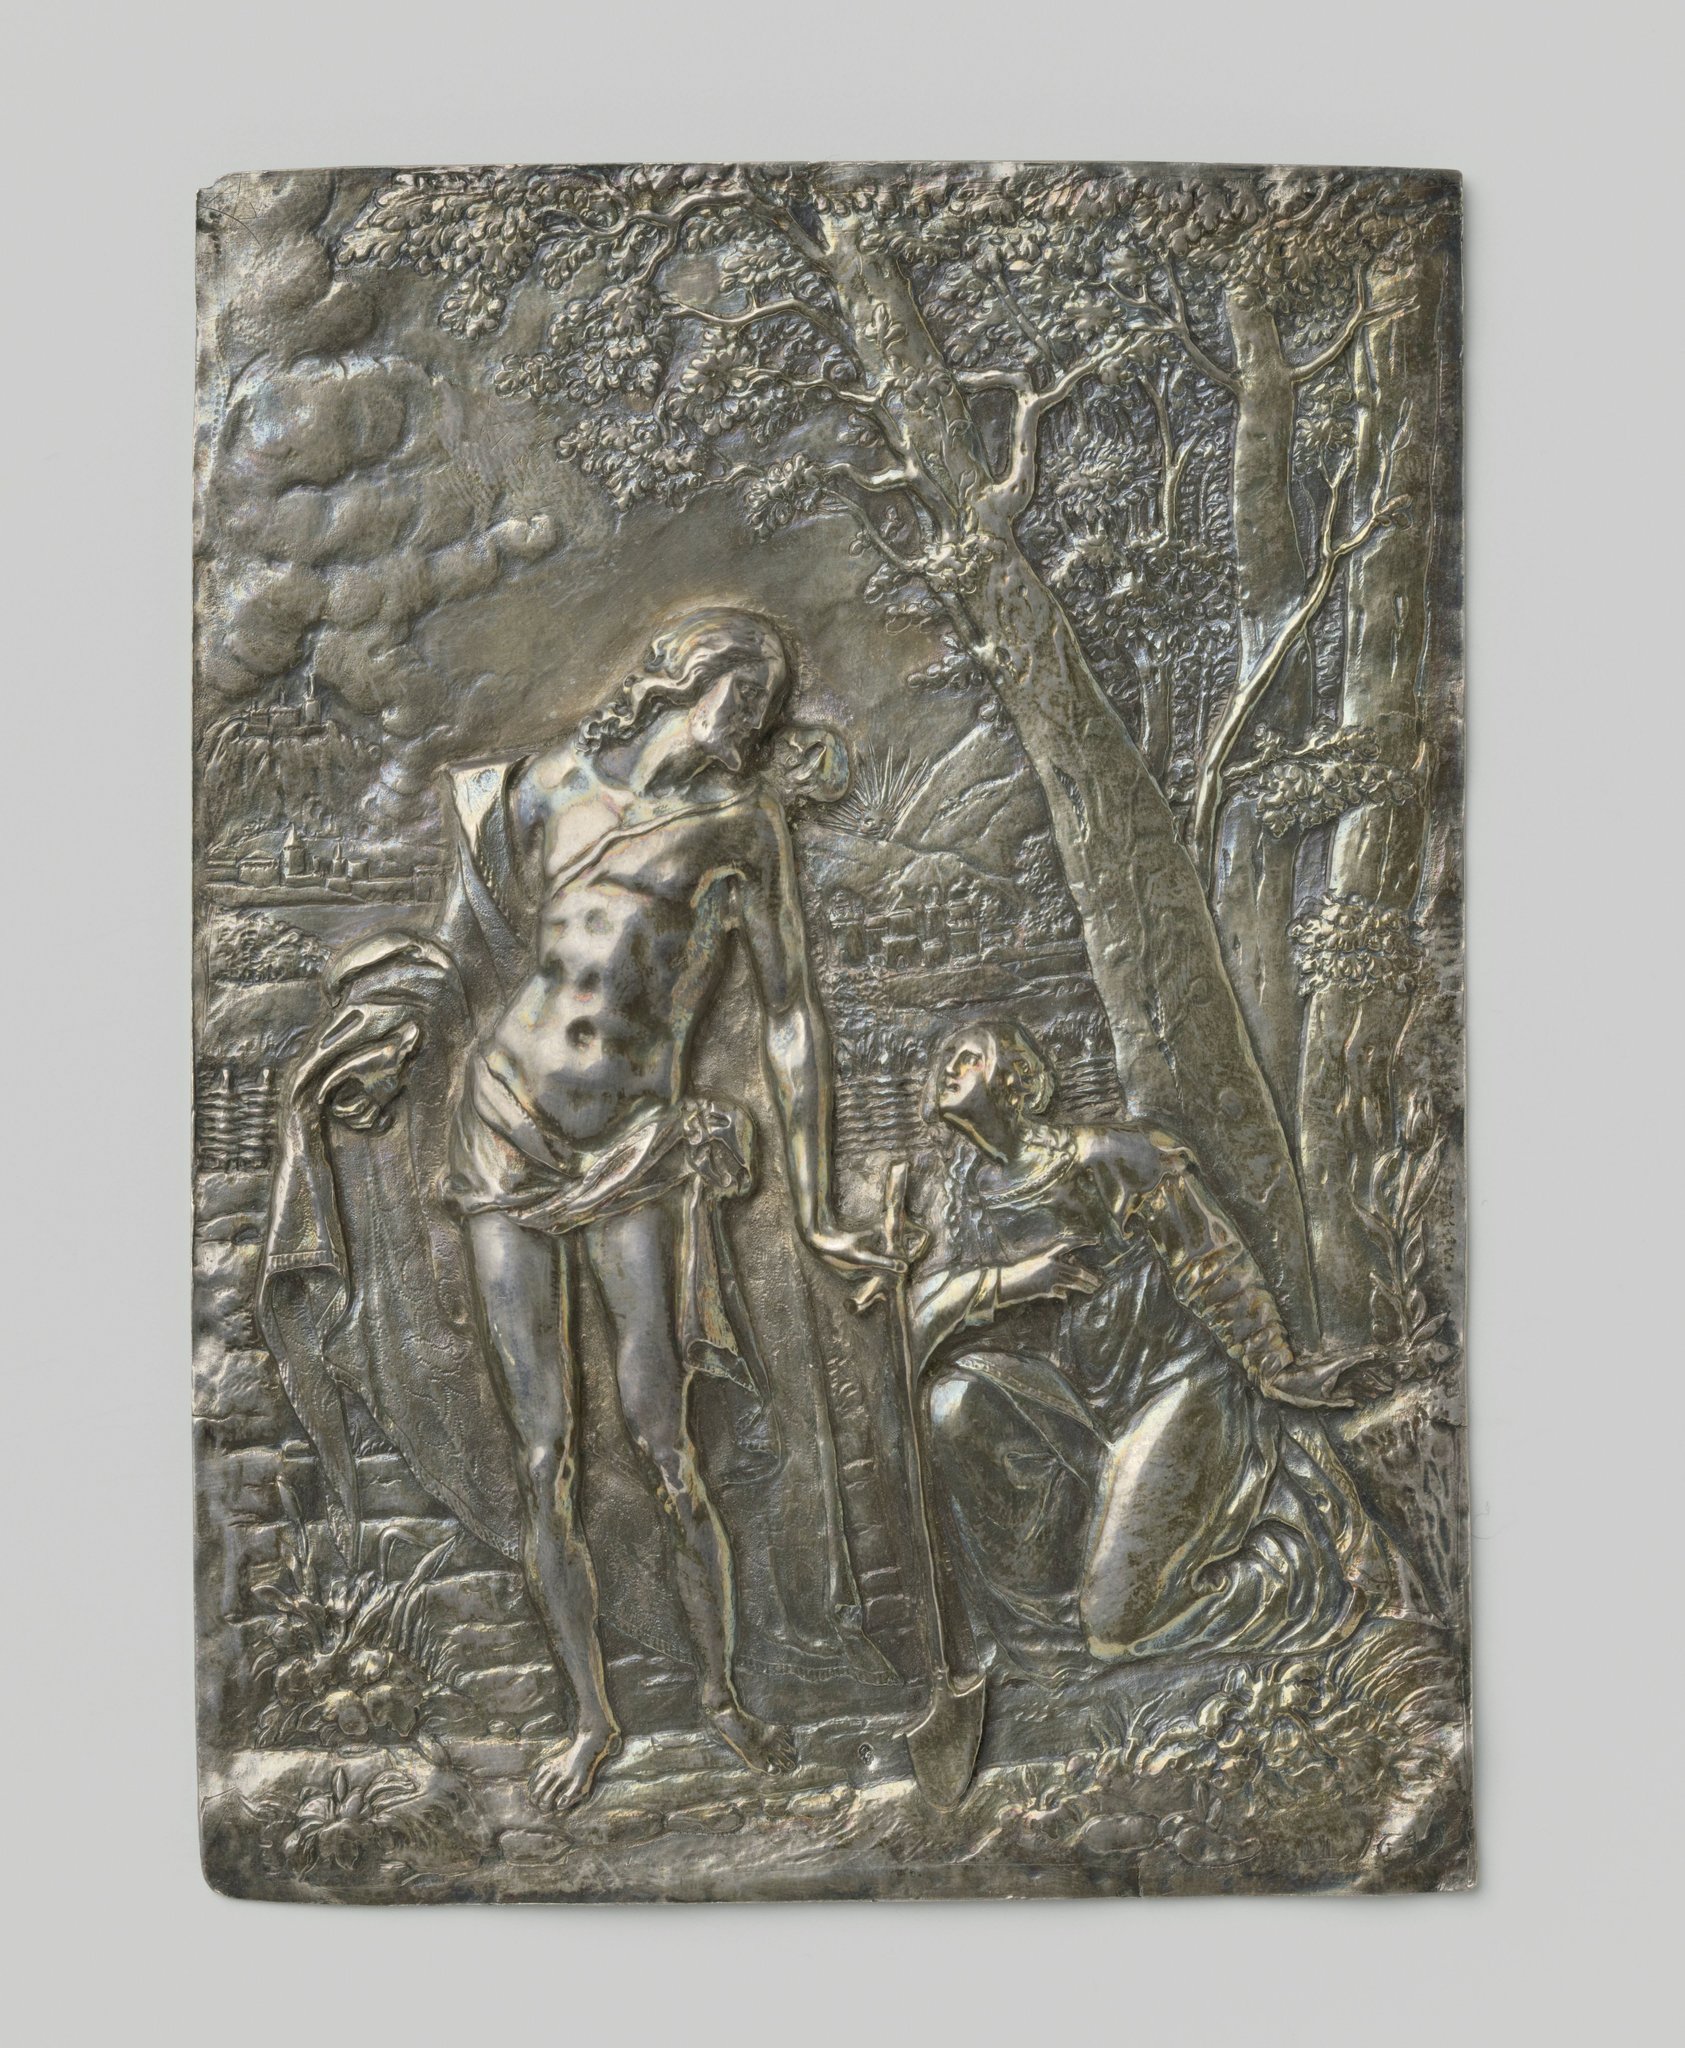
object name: plaque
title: Christus als hovenier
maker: joost lutma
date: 1649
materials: silver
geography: netherlands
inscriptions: date: ‘1649’, monogram: ‘I L’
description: Rechthoekige, zilveren plaquette. De Christusfiguur draagt een lendendoek en een over de schouders afhangende, wijd geplooide mantel. Met een schop in zijn linkerhand beweegt hij zich naar links, terwijl hij omziet neer de rechts van hem knielende Maria-Magdalena. Achter haar een zware boomgroep. Links, achter een gevlochten afrastering, een berglandschap met gebouwen.